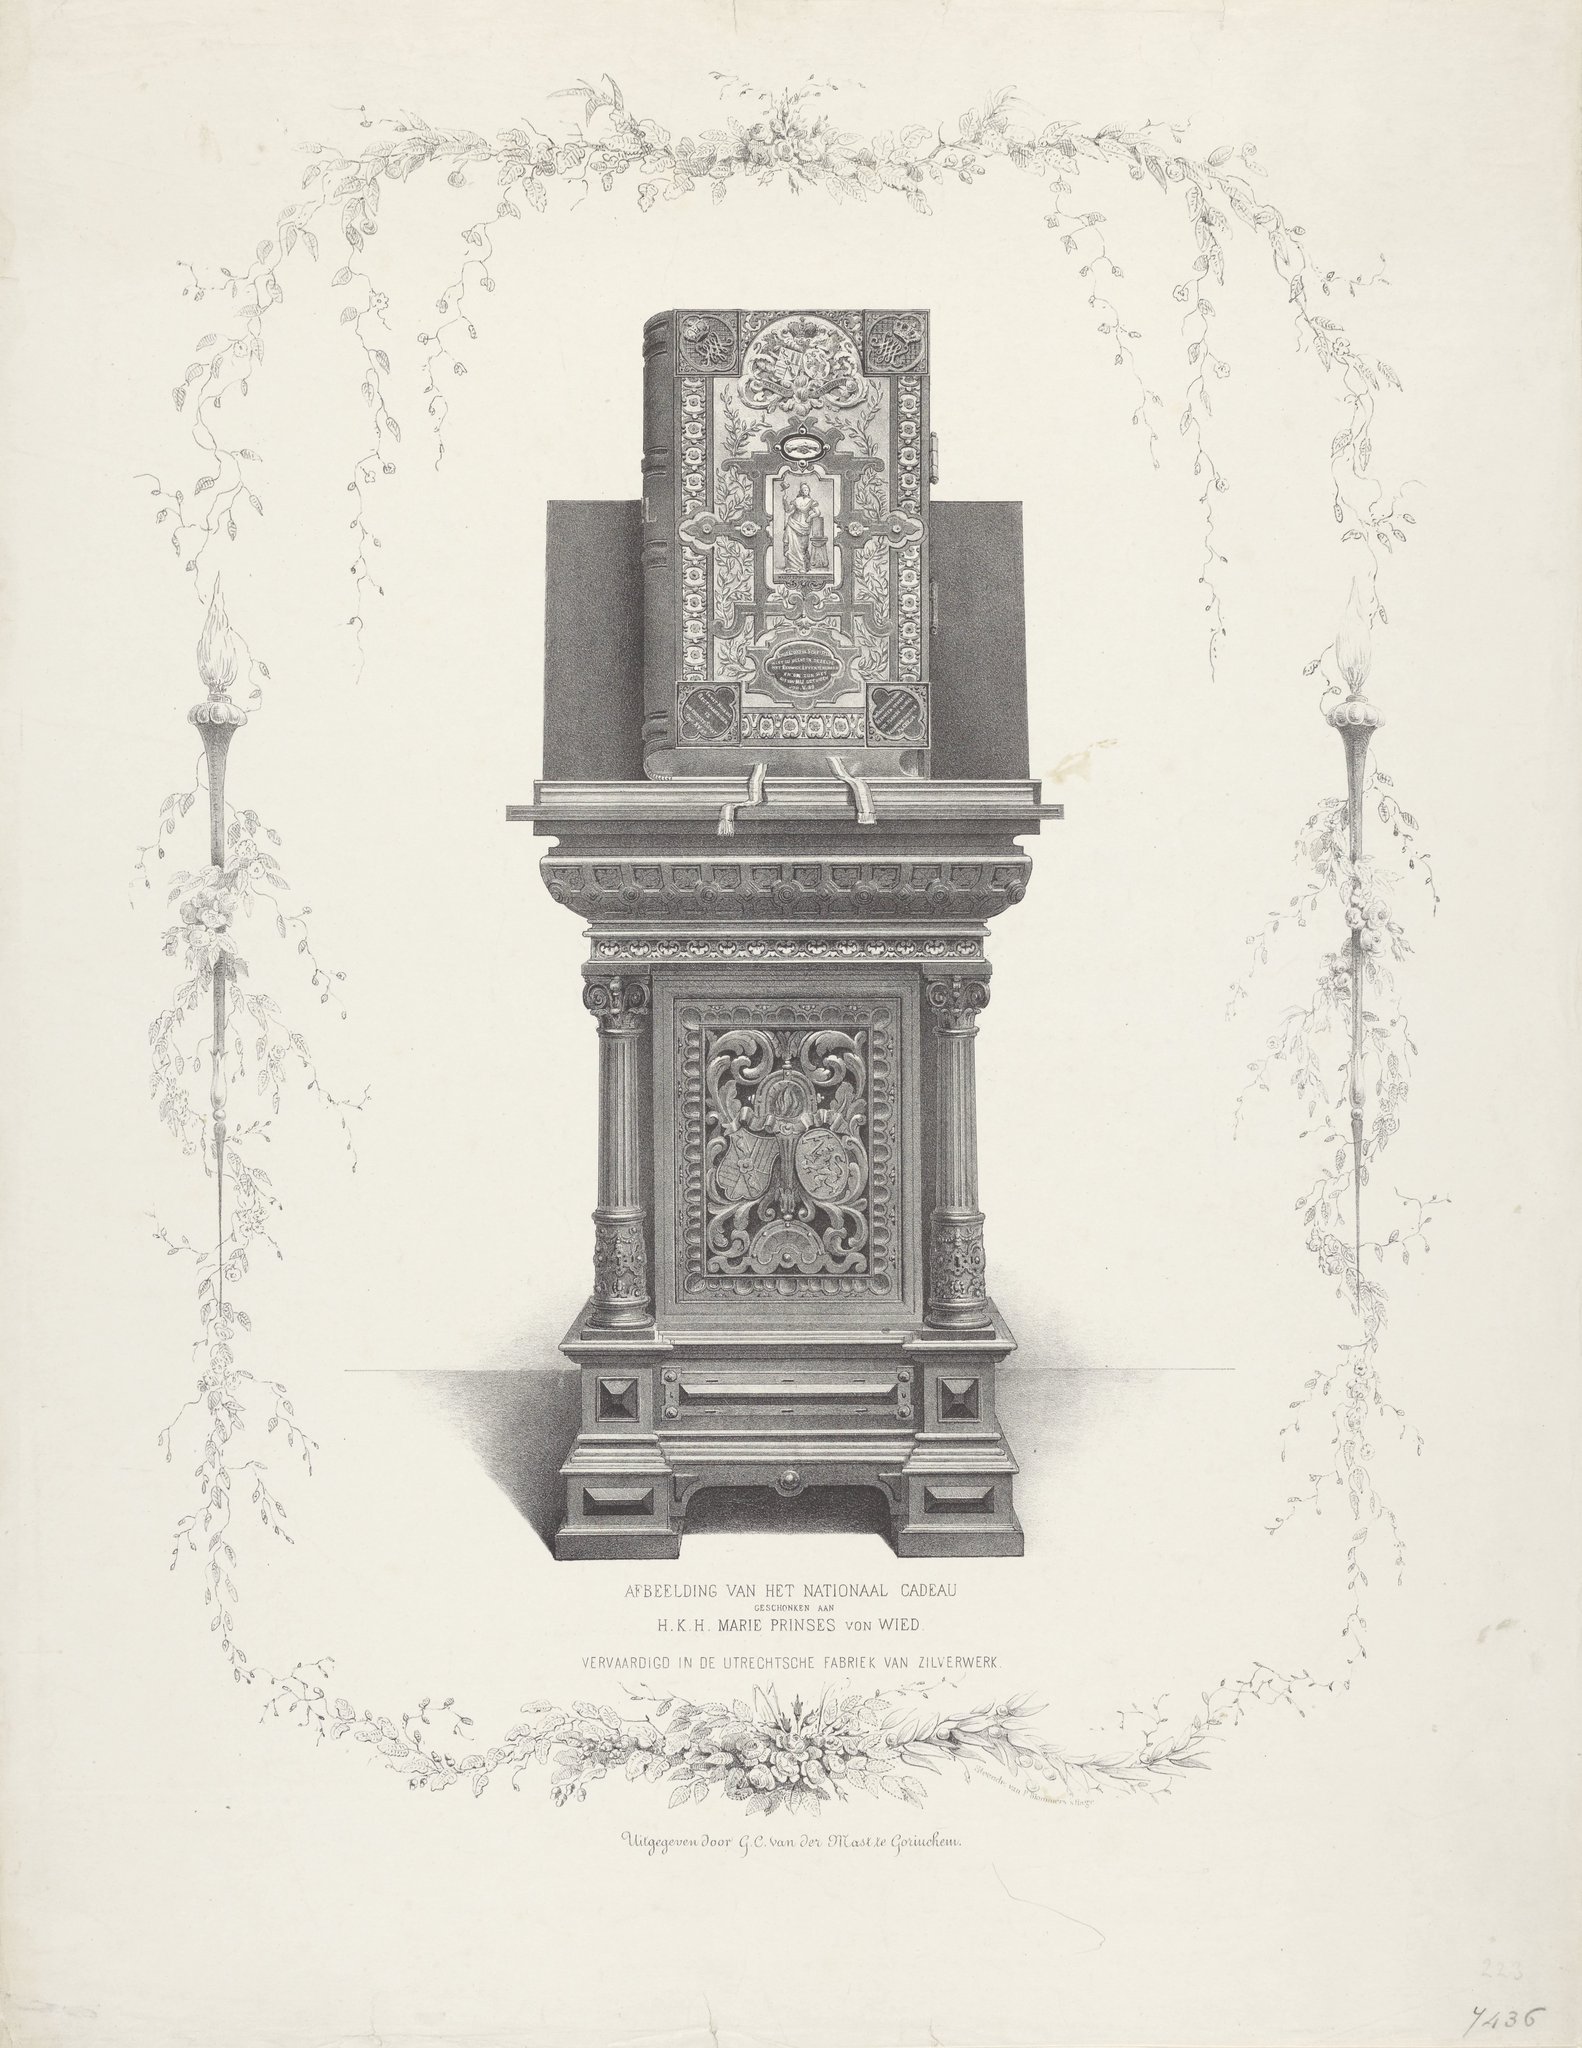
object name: print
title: Nationaal Cadeau geschonken aan prinses Marie bij haar huwelijk in 1871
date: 1871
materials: paper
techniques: lithograph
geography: gorinchem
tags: the bible as a book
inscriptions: collector's mark: Lugt 2228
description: Een met zilverwerk versierde bijbel staande op een houten standaard. Het Nationaal Cadeau geschonken aan prinses Marie bij haar huwelijk op 18 juli 1871 met de vorst Willem Adolf van Wied. Binnen een omlijsting van bladranken, bloemen en toortsen.